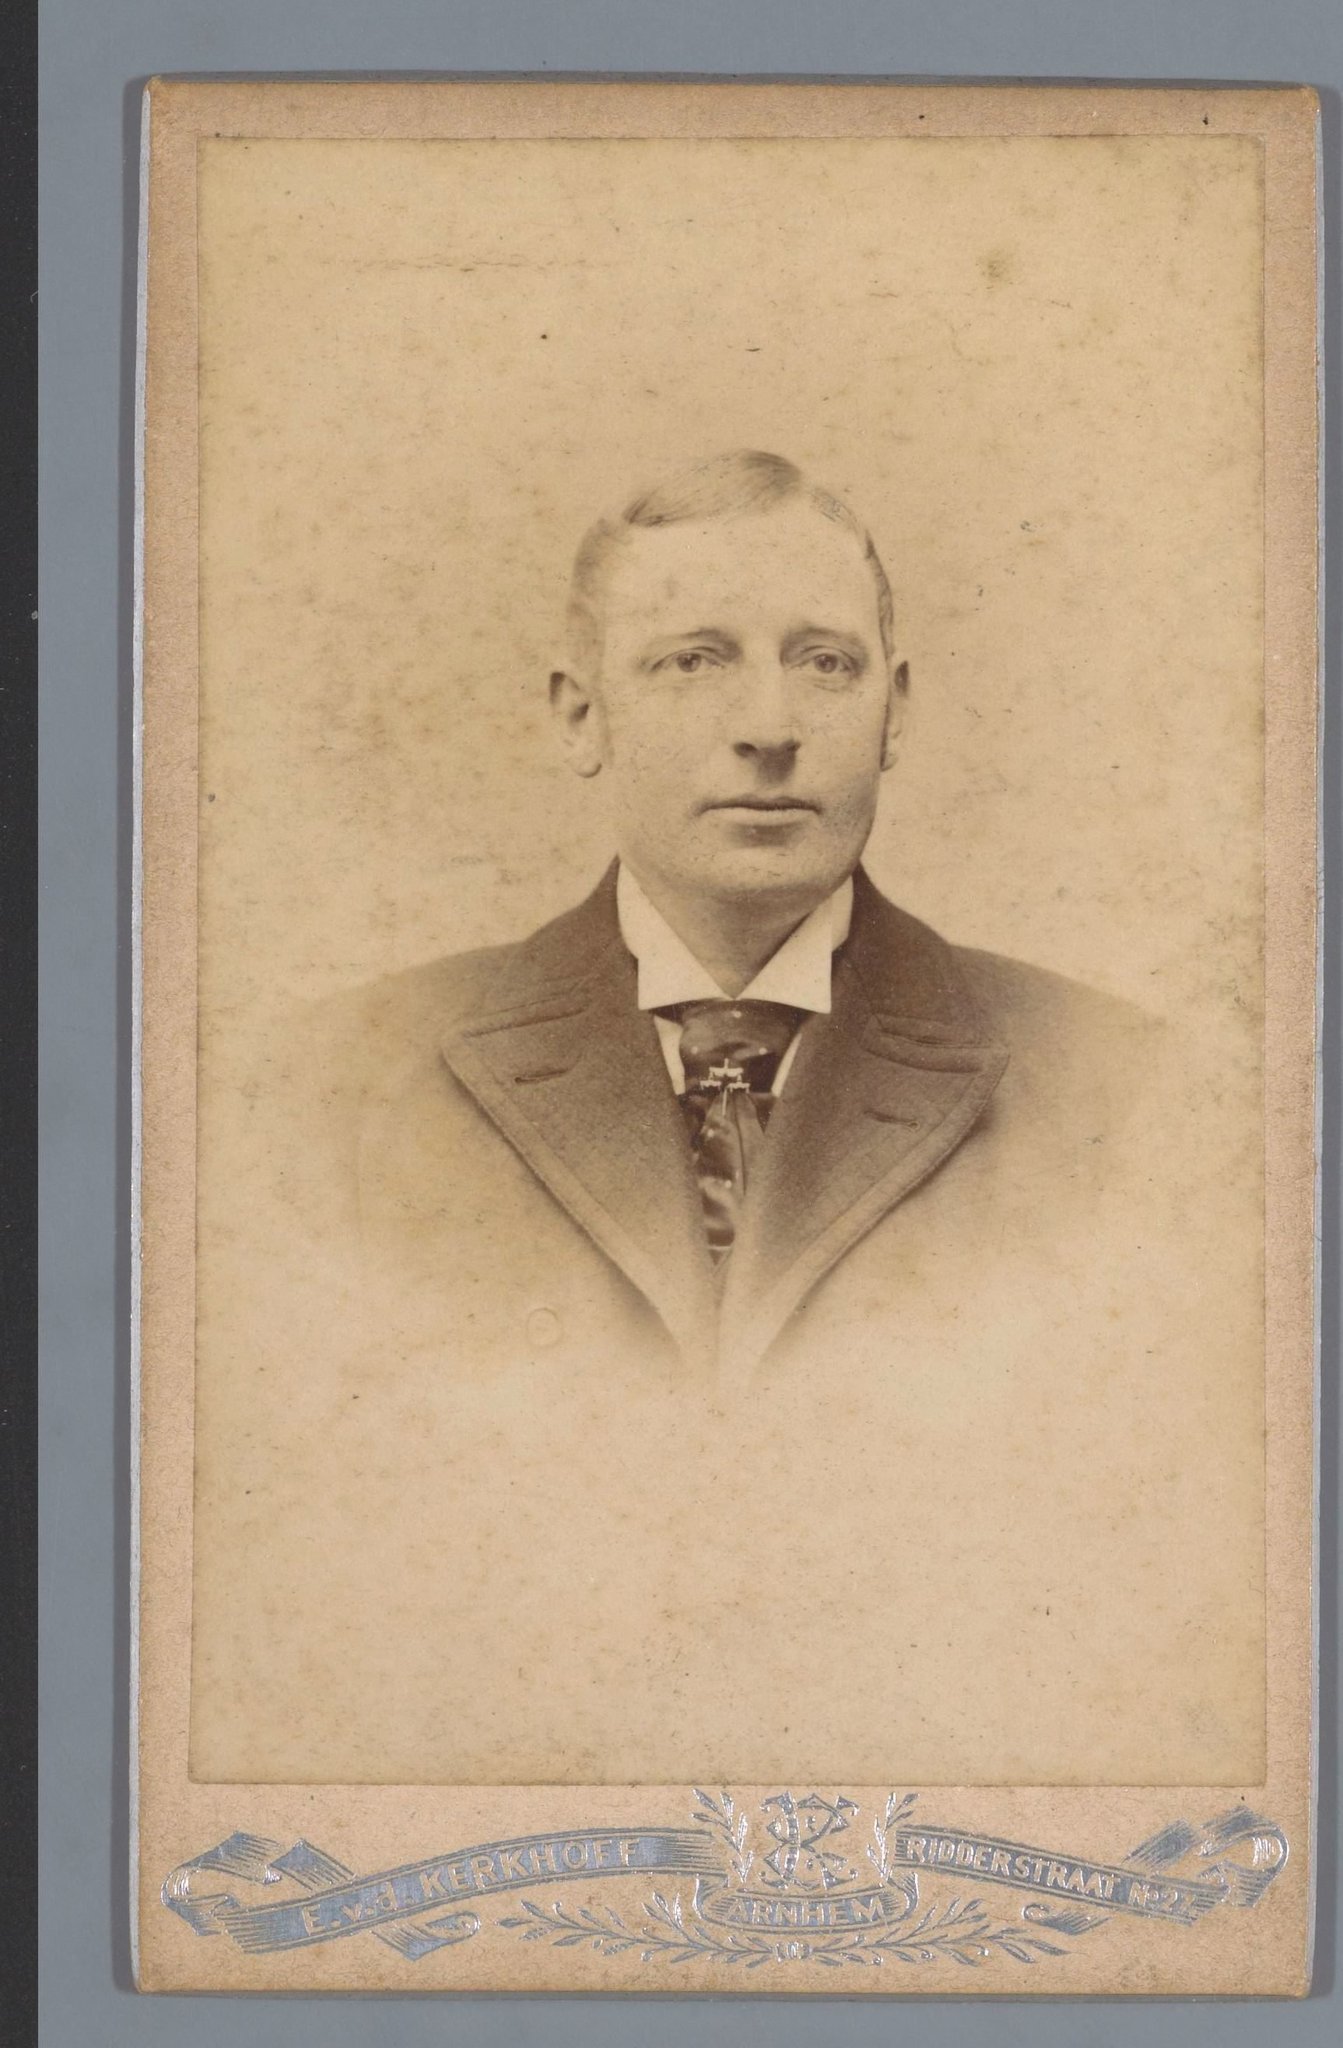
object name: photograph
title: Portret van een onbekende man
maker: e. v.d. kerkhoff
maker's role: fotograaf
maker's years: 1861-1943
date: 1895-1908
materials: cardboard, paper, photographic support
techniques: albumen print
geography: amsterdam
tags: adult man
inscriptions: name: ‘E v.d. Kerkhoff Ridderstraat No. 27 Arnhem’, name: ‘E v.d. Kerkhoff Arnhem Ridderstraat No. 27.’